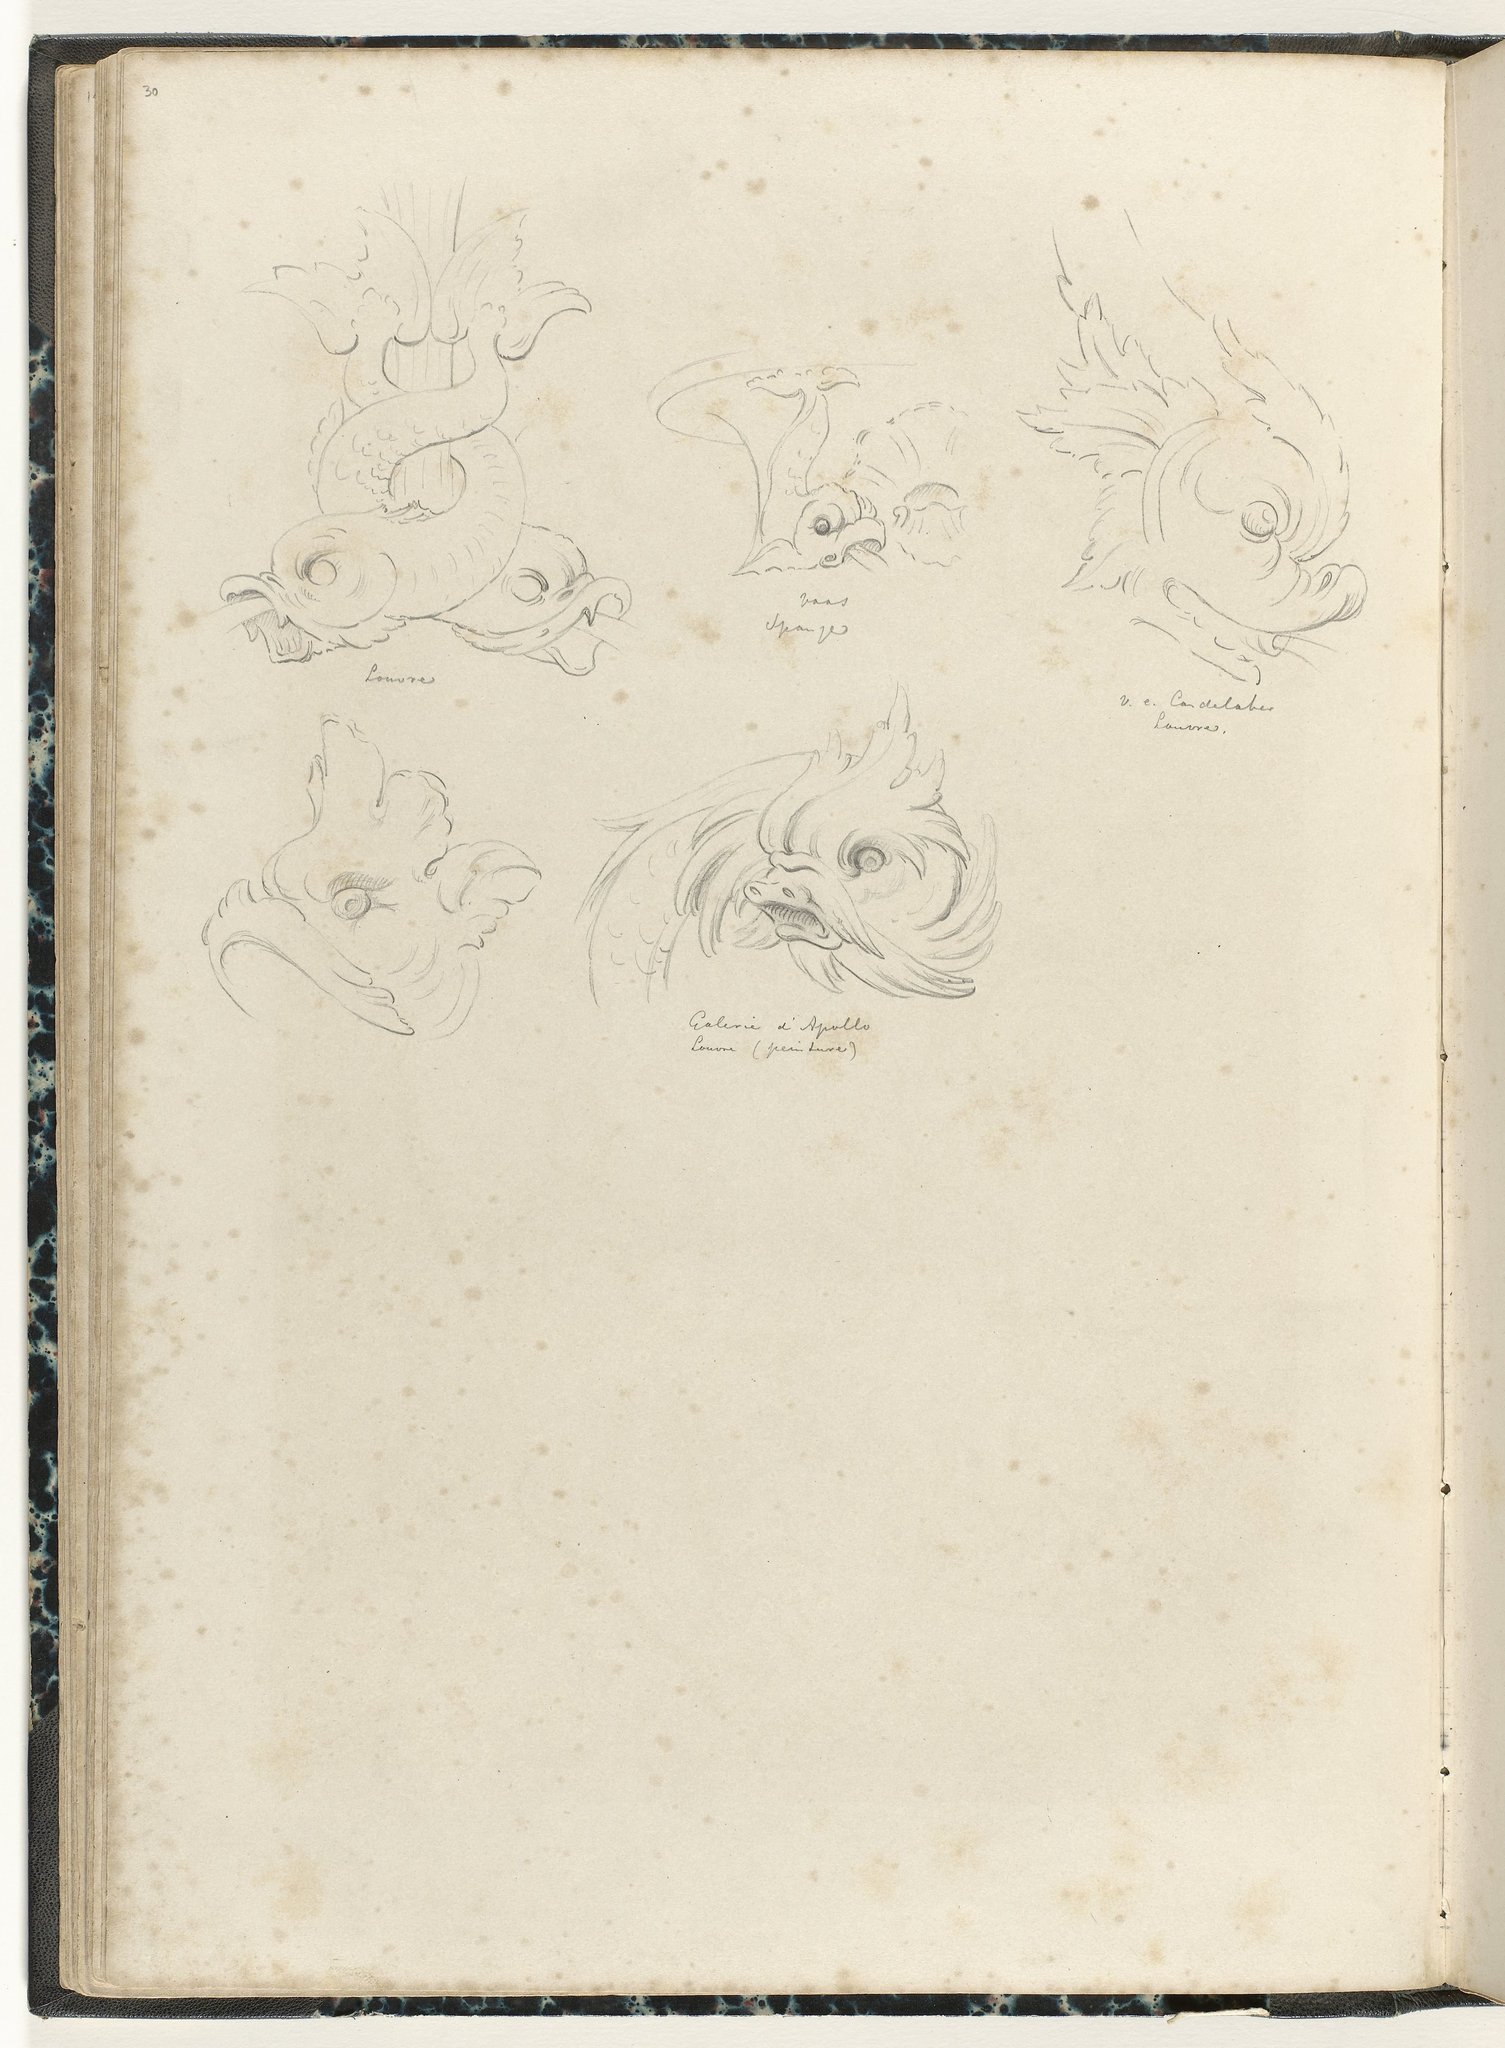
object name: drawing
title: Vijf ornamenten in de vorm van dolfijnen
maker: Anonymous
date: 1866-1900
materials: paper, pencil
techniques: drawing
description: Bovenaan staan drie ornamenten met dolfijnen voor fonteinen afgebeeld, de twee dolfijnen links zijn rond een paal verstrengeld.